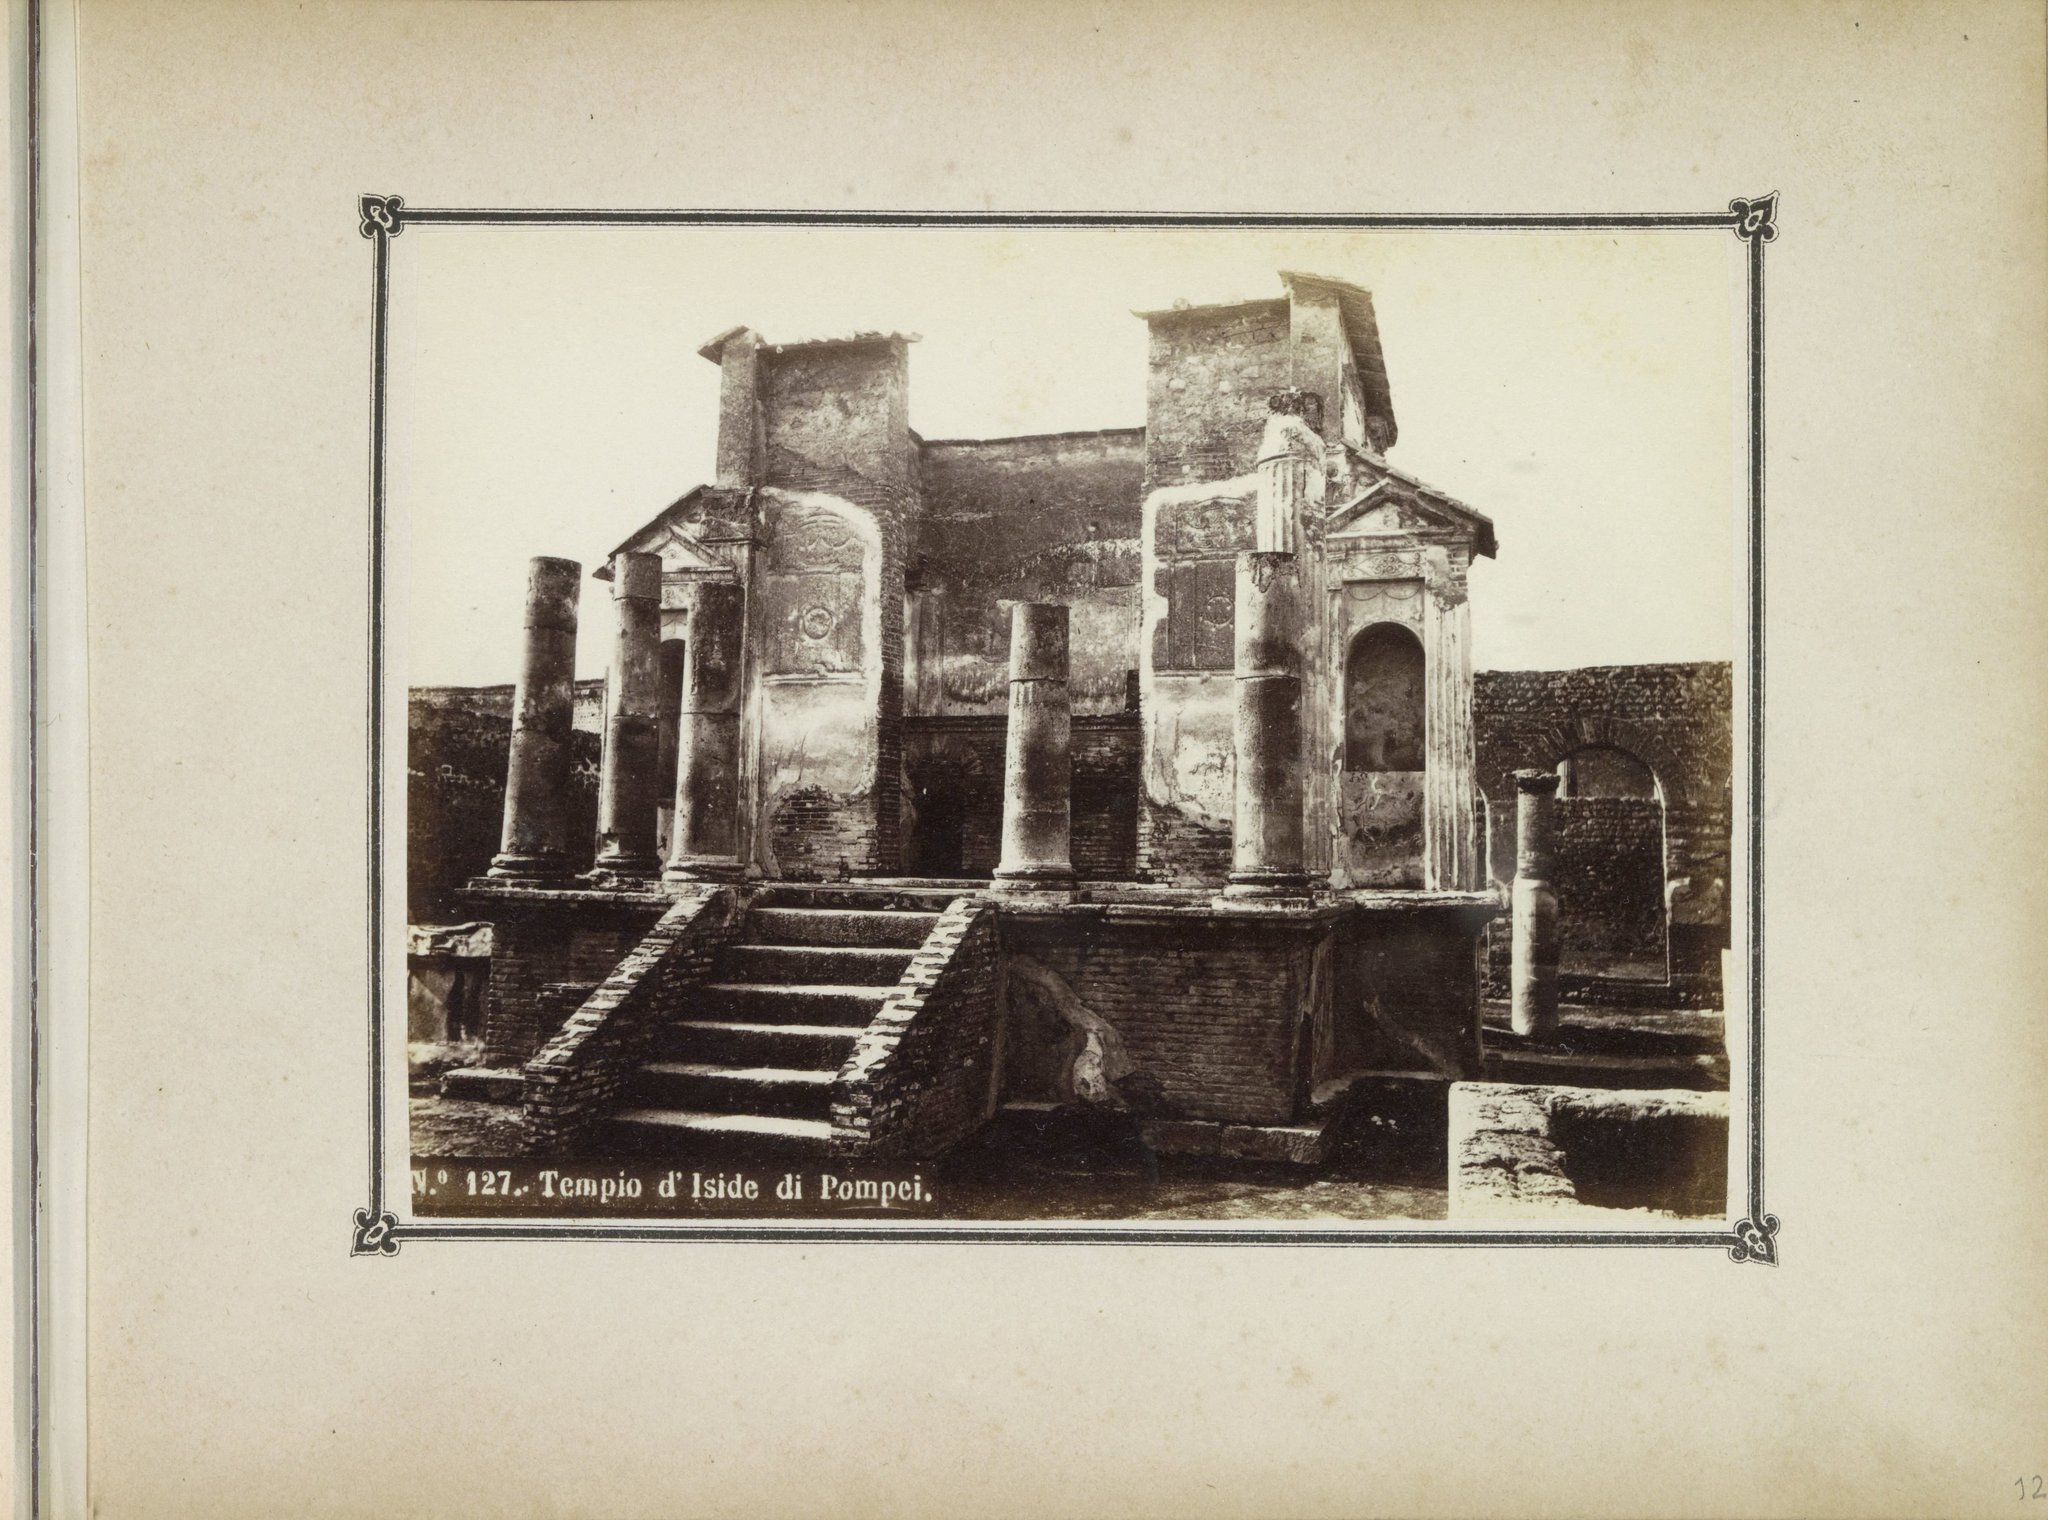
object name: photograph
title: Restanten van de Isistempel in Pompeï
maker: roberto rive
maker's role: fotograaf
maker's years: 1825-1868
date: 1860-1900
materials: paper, photographic support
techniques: albumen print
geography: pompeii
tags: temple, shrine ~ roman religion, excavation ~ archaeology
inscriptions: number: ‘127’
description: Onderdeel van Fotoalbum met opnames van opgravingen in Pompeï door Roberto Rive.